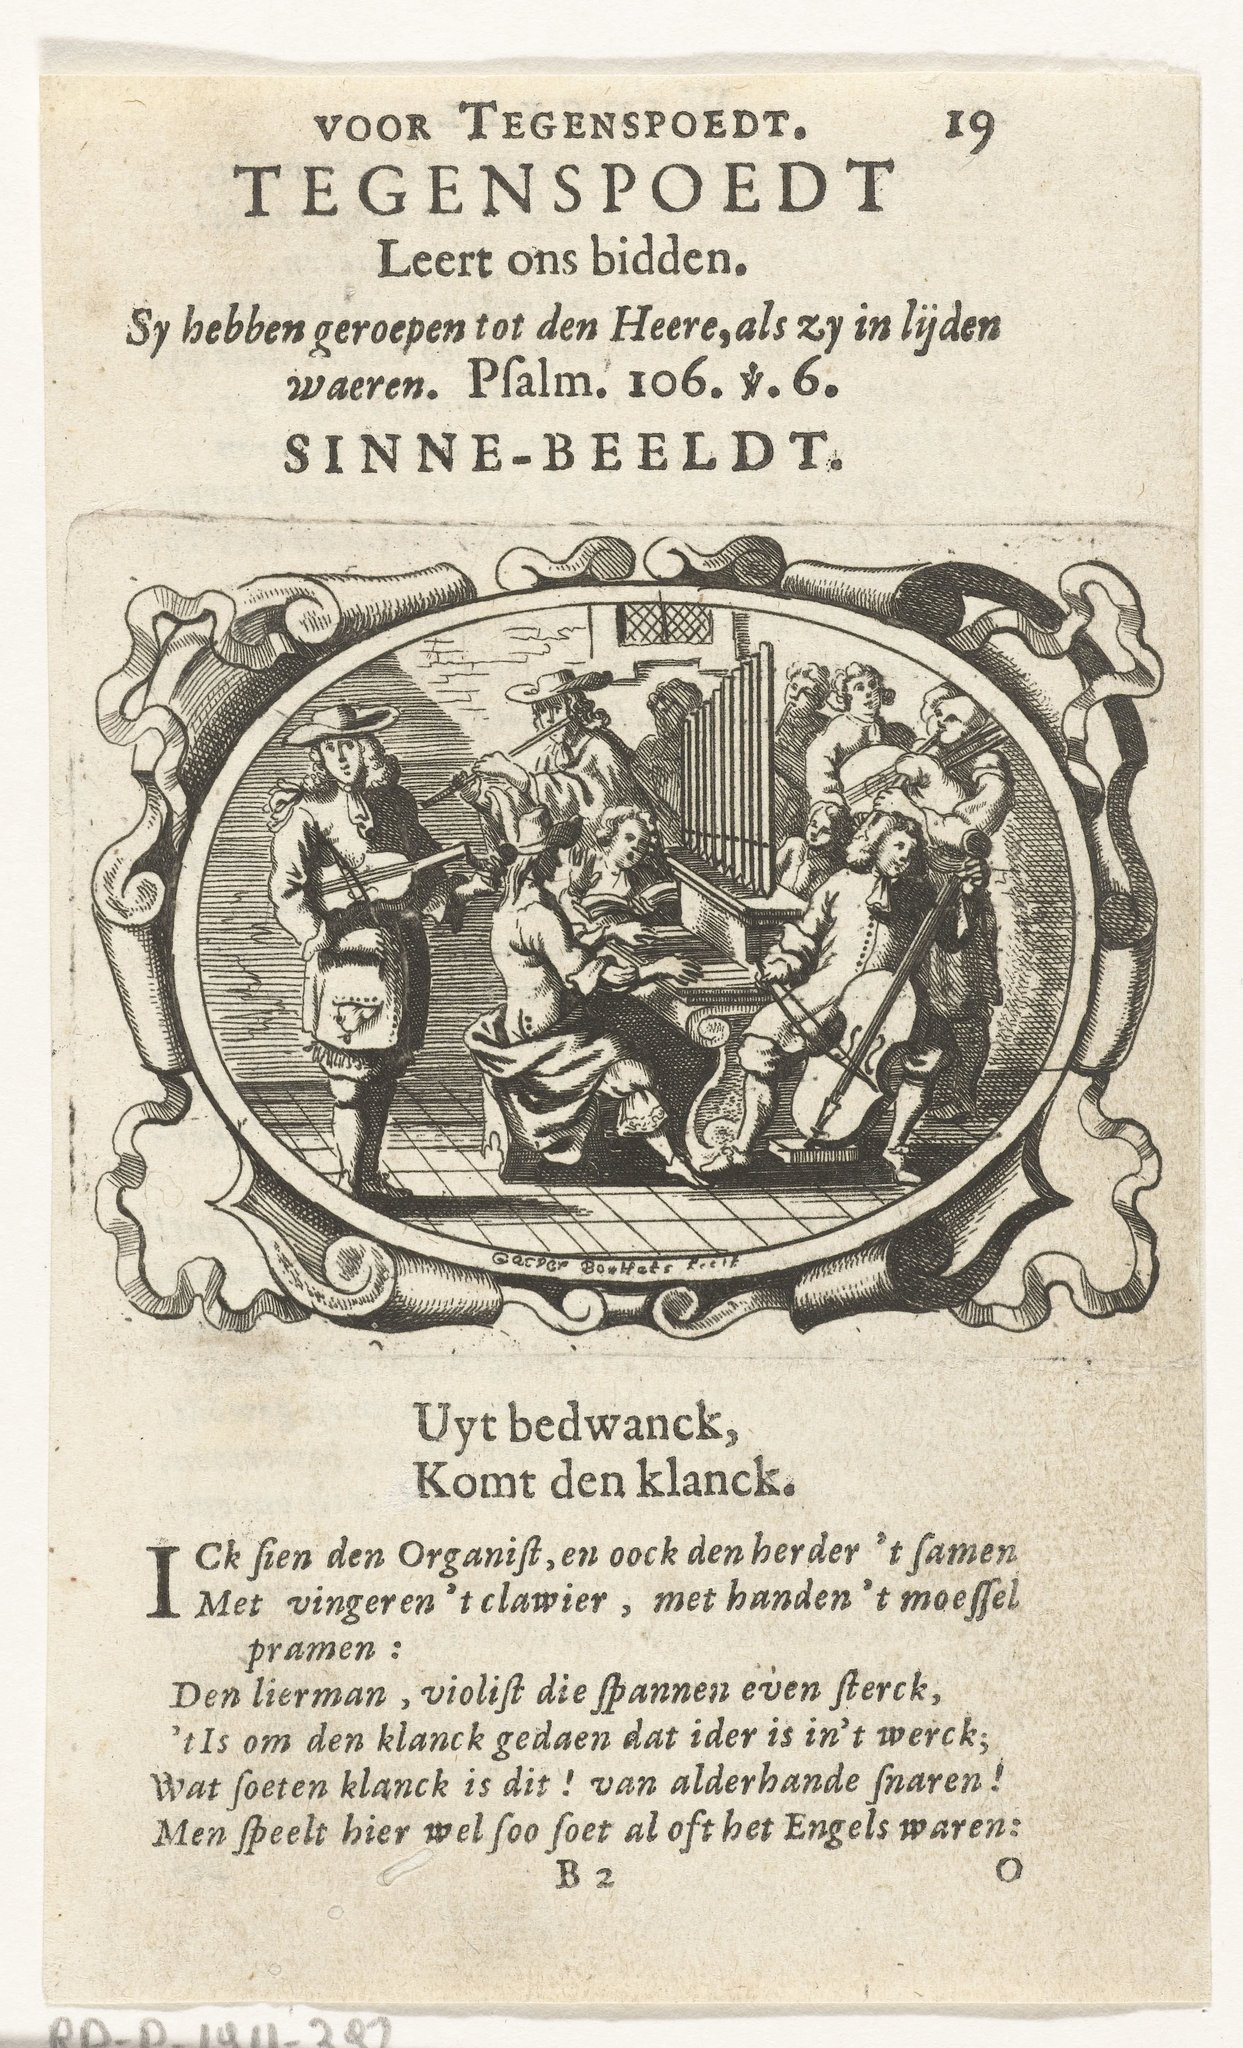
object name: print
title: Tegenspoed leert bidden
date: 1679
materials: paper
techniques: engraving, etching, letterpress printing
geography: diest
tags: small group of musicians, chamber orchestra, jazz band, adversity, misfortune, bad luck; 'fortuna infelice', 'infortunio' (ripa), abstract ideas and concepts (+ emblematical representation of concept)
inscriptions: collector's mark: Lugt 2228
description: Bladzijde uit een boek (p. 19) met tekst op verso. In een ovale cartouche een kamerorkest in actie. het orkest telt 10 leden. Er wordt gespeeld op de viool, de cello, fluit. doedelzak, luit en klavier. Enkele orkestleden zingen. Boven de cartouche de titel (motto) van de prent en een citaat uit de bijbel (Psalm 106:6). Onder de prent een onderschrift: 'Uyt bedwanck komt klanck' en een beschrijving die vertelt dat bidden soelaas brengt in moeilijke tijden.